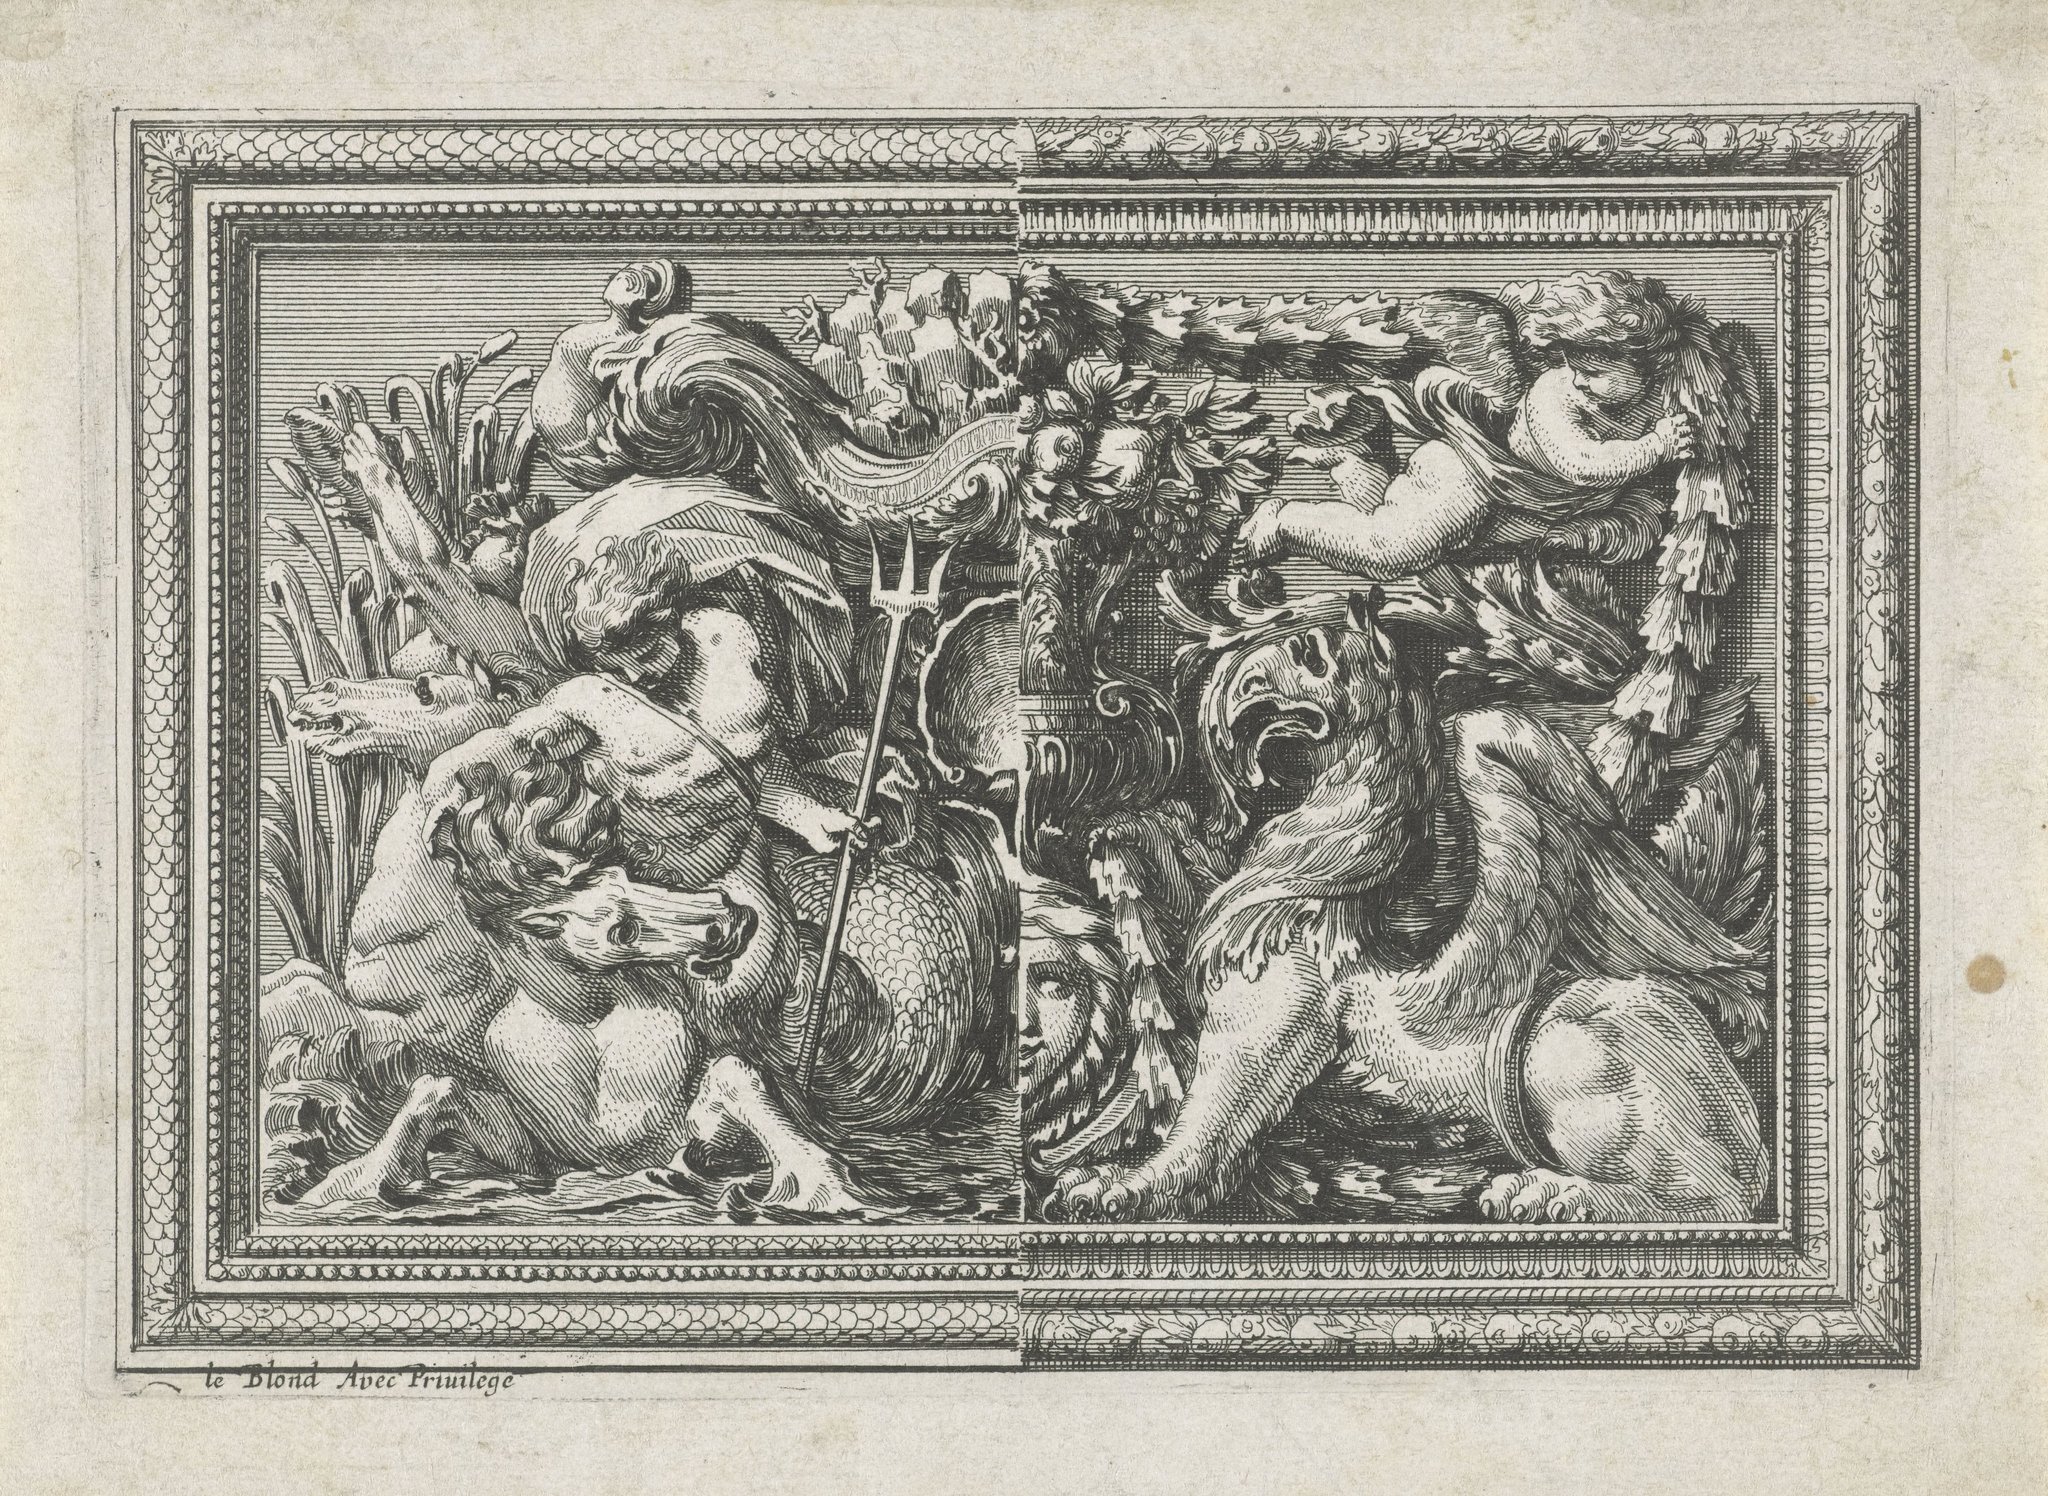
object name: print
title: Ornamenteel paneel in lijst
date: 1650-1666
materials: paper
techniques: etching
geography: paris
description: Paneel met variant voor rechterhelft, links Neptunus en een zeepaard, rechts een griffioen. Uit serie van 12 bladen, eerste editie.